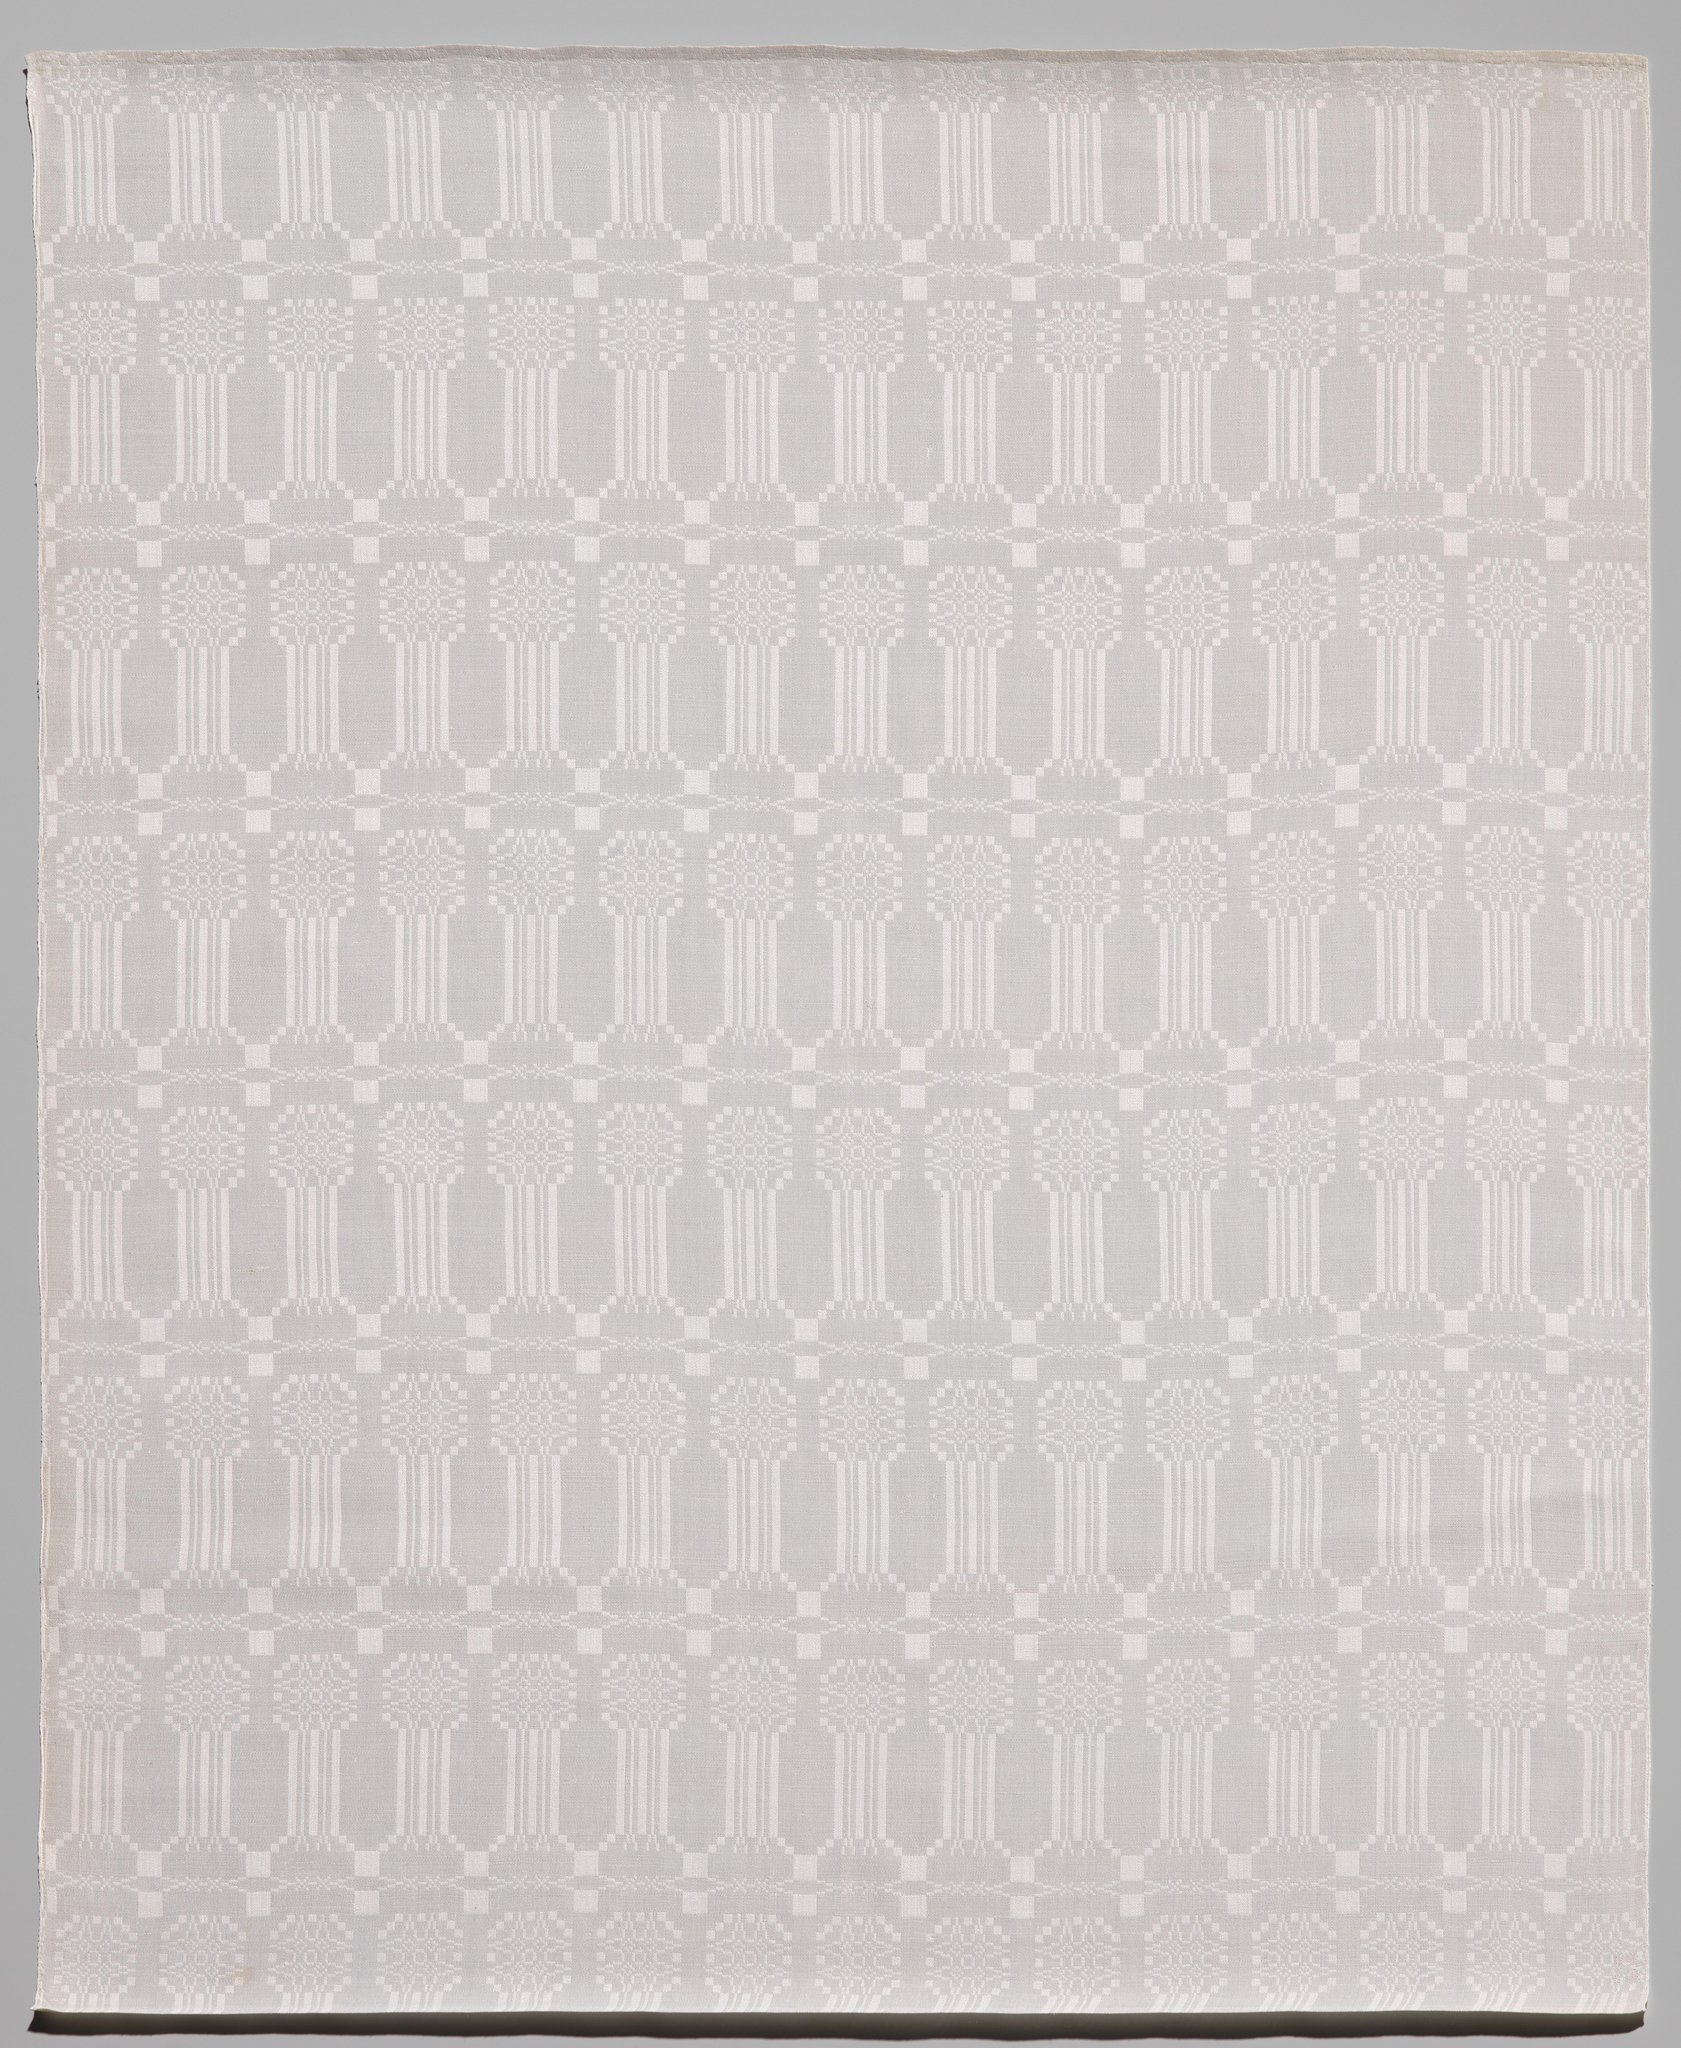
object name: napkin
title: Servet van linnen met pellenpatroon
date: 1734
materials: linen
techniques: peeled fabric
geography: northern netherlands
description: Servet van wit linnen met pellenpatroon "oranjeboom", merk WG 60 1734.